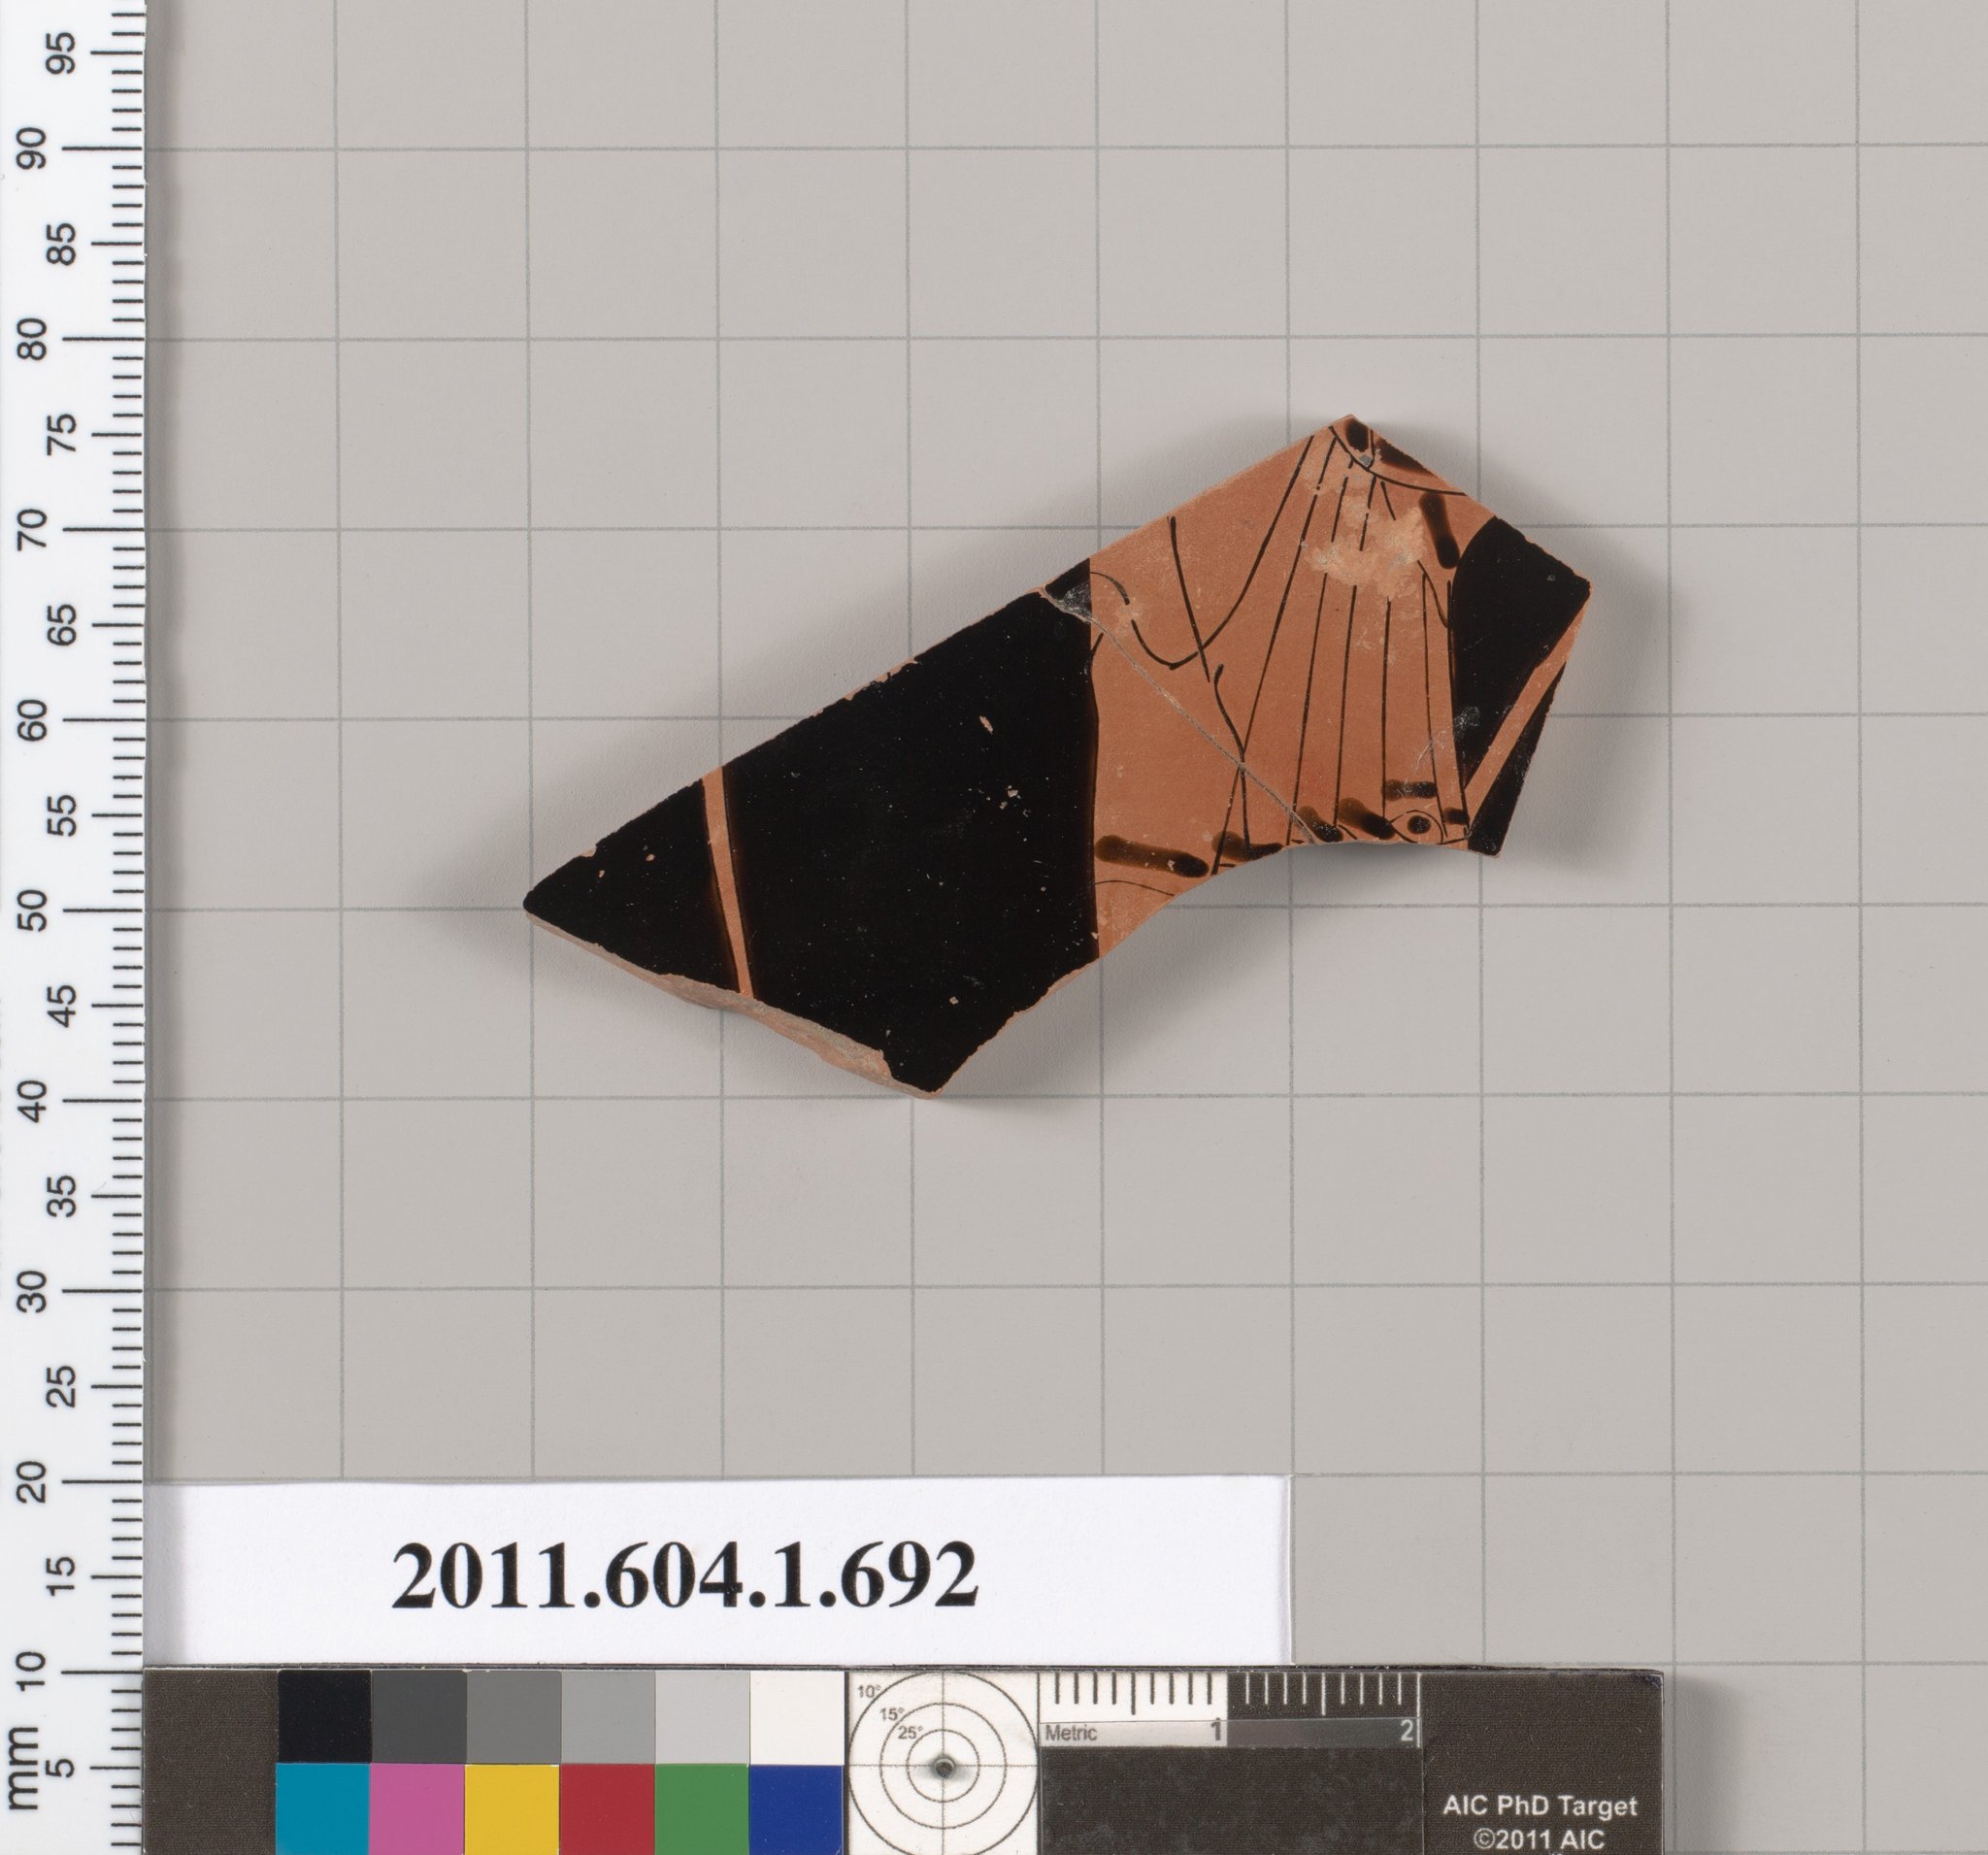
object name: kylix fragment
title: Terracotta fragment of a kylix (drinking cup)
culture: greek, attic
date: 475-451 BCE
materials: terracotta